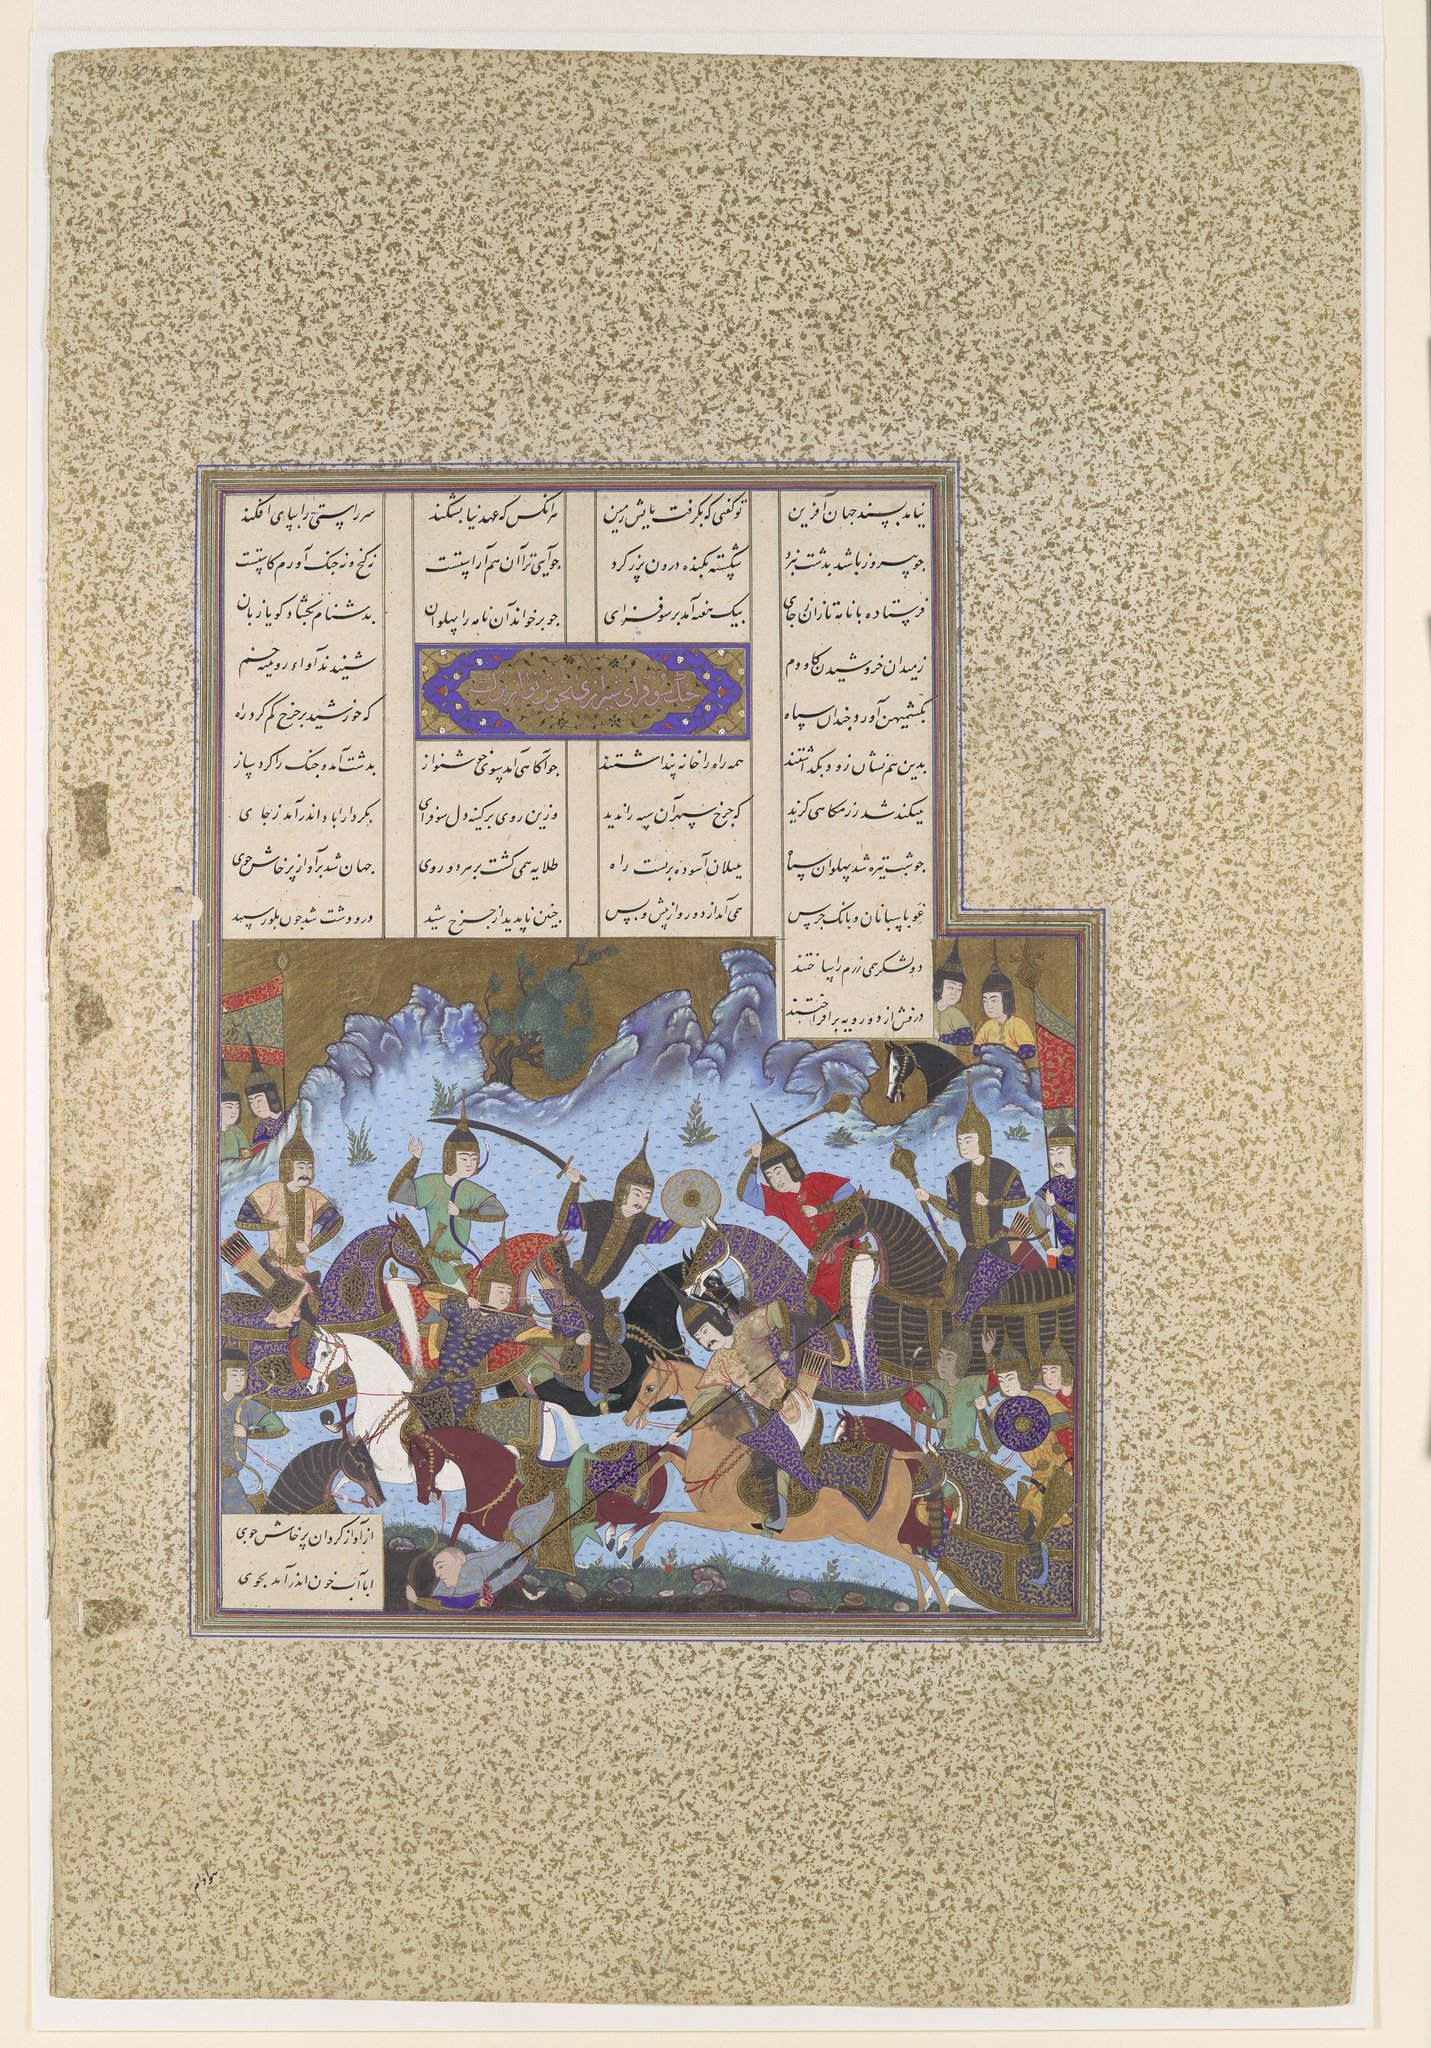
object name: folio from an illustrated manuscript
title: "Sufarai's Victory over the Haital", Folio 595v from the Shahnama (Book of Kings) of Shah Tahmasp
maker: abu'l qasim firdausi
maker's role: author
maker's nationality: iranian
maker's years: 935-1020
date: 1530-1535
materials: gold, ink, paper, silver, watercolor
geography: iran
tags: battles,men,horses